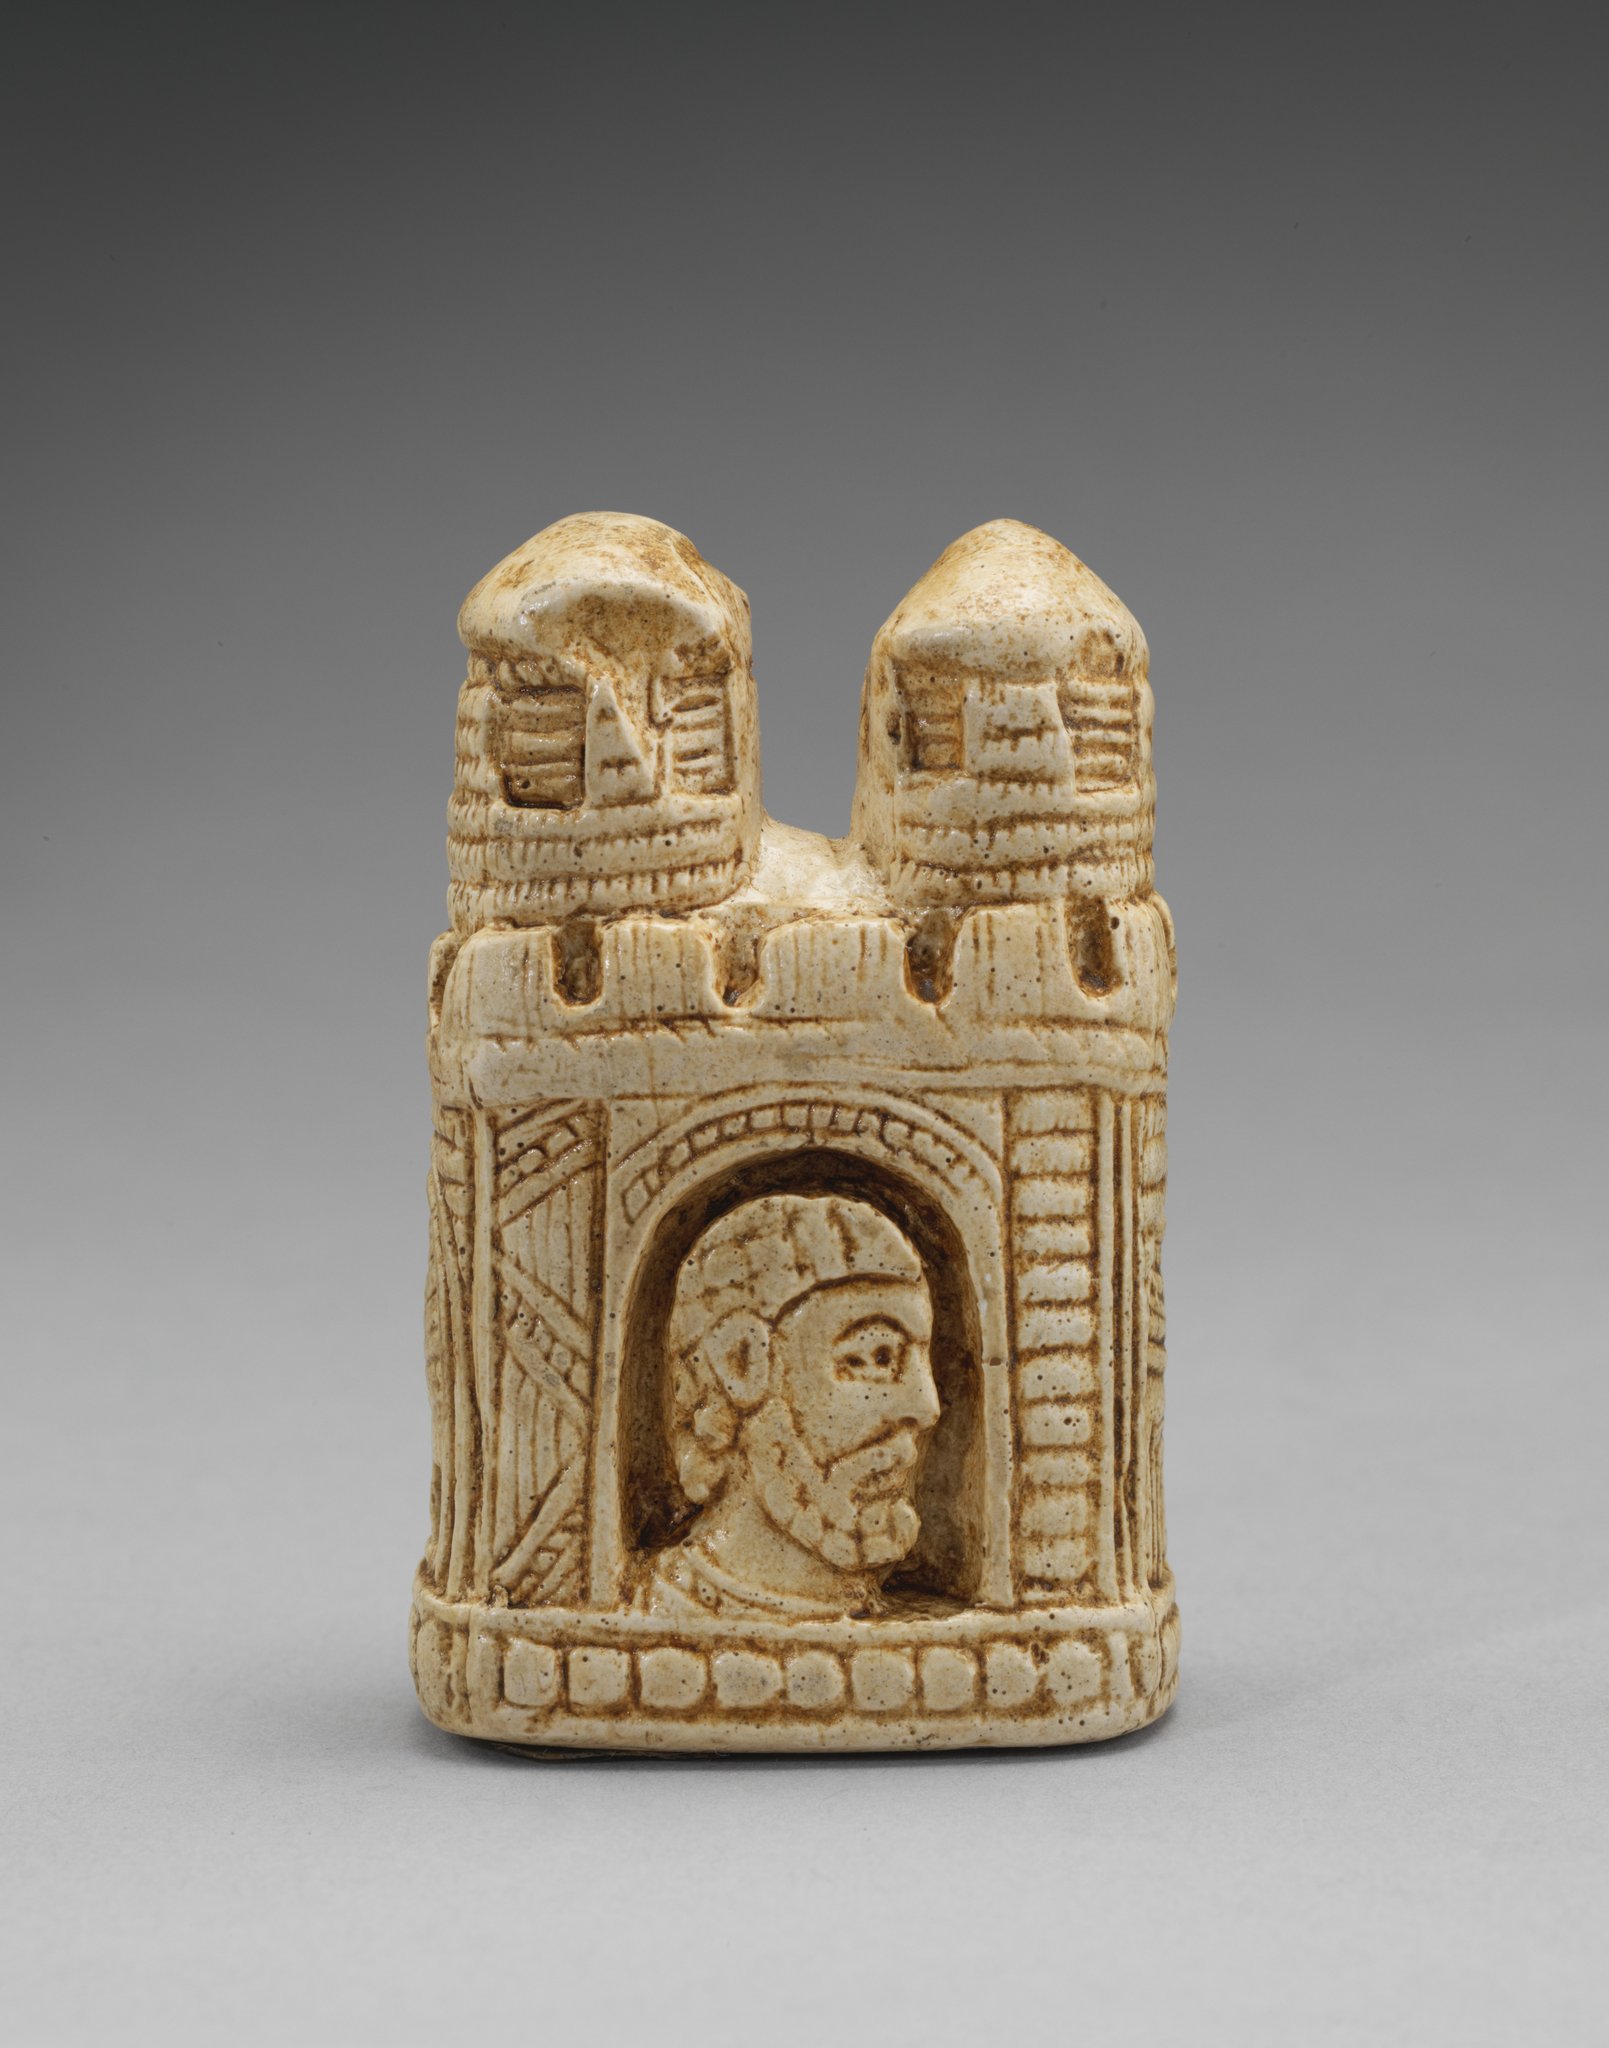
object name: chessman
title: Chessman (King)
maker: elkington & co.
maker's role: manufacturer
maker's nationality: british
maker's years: 1829-1963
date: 1870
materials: ivory, plaster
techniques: painting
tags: chess